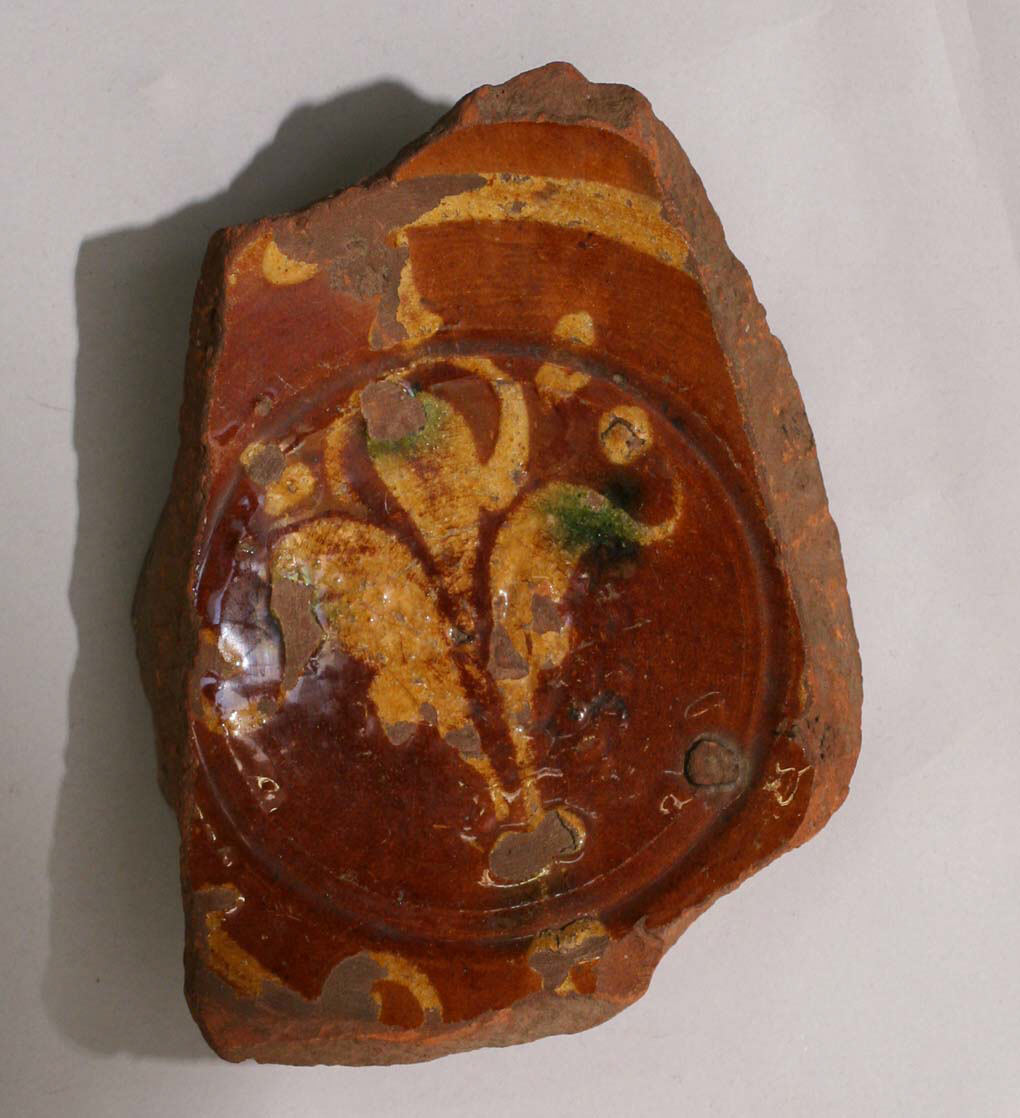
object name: ceramic fragment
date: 1301-1500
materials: earthenware, glaze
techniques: painting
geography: egypt